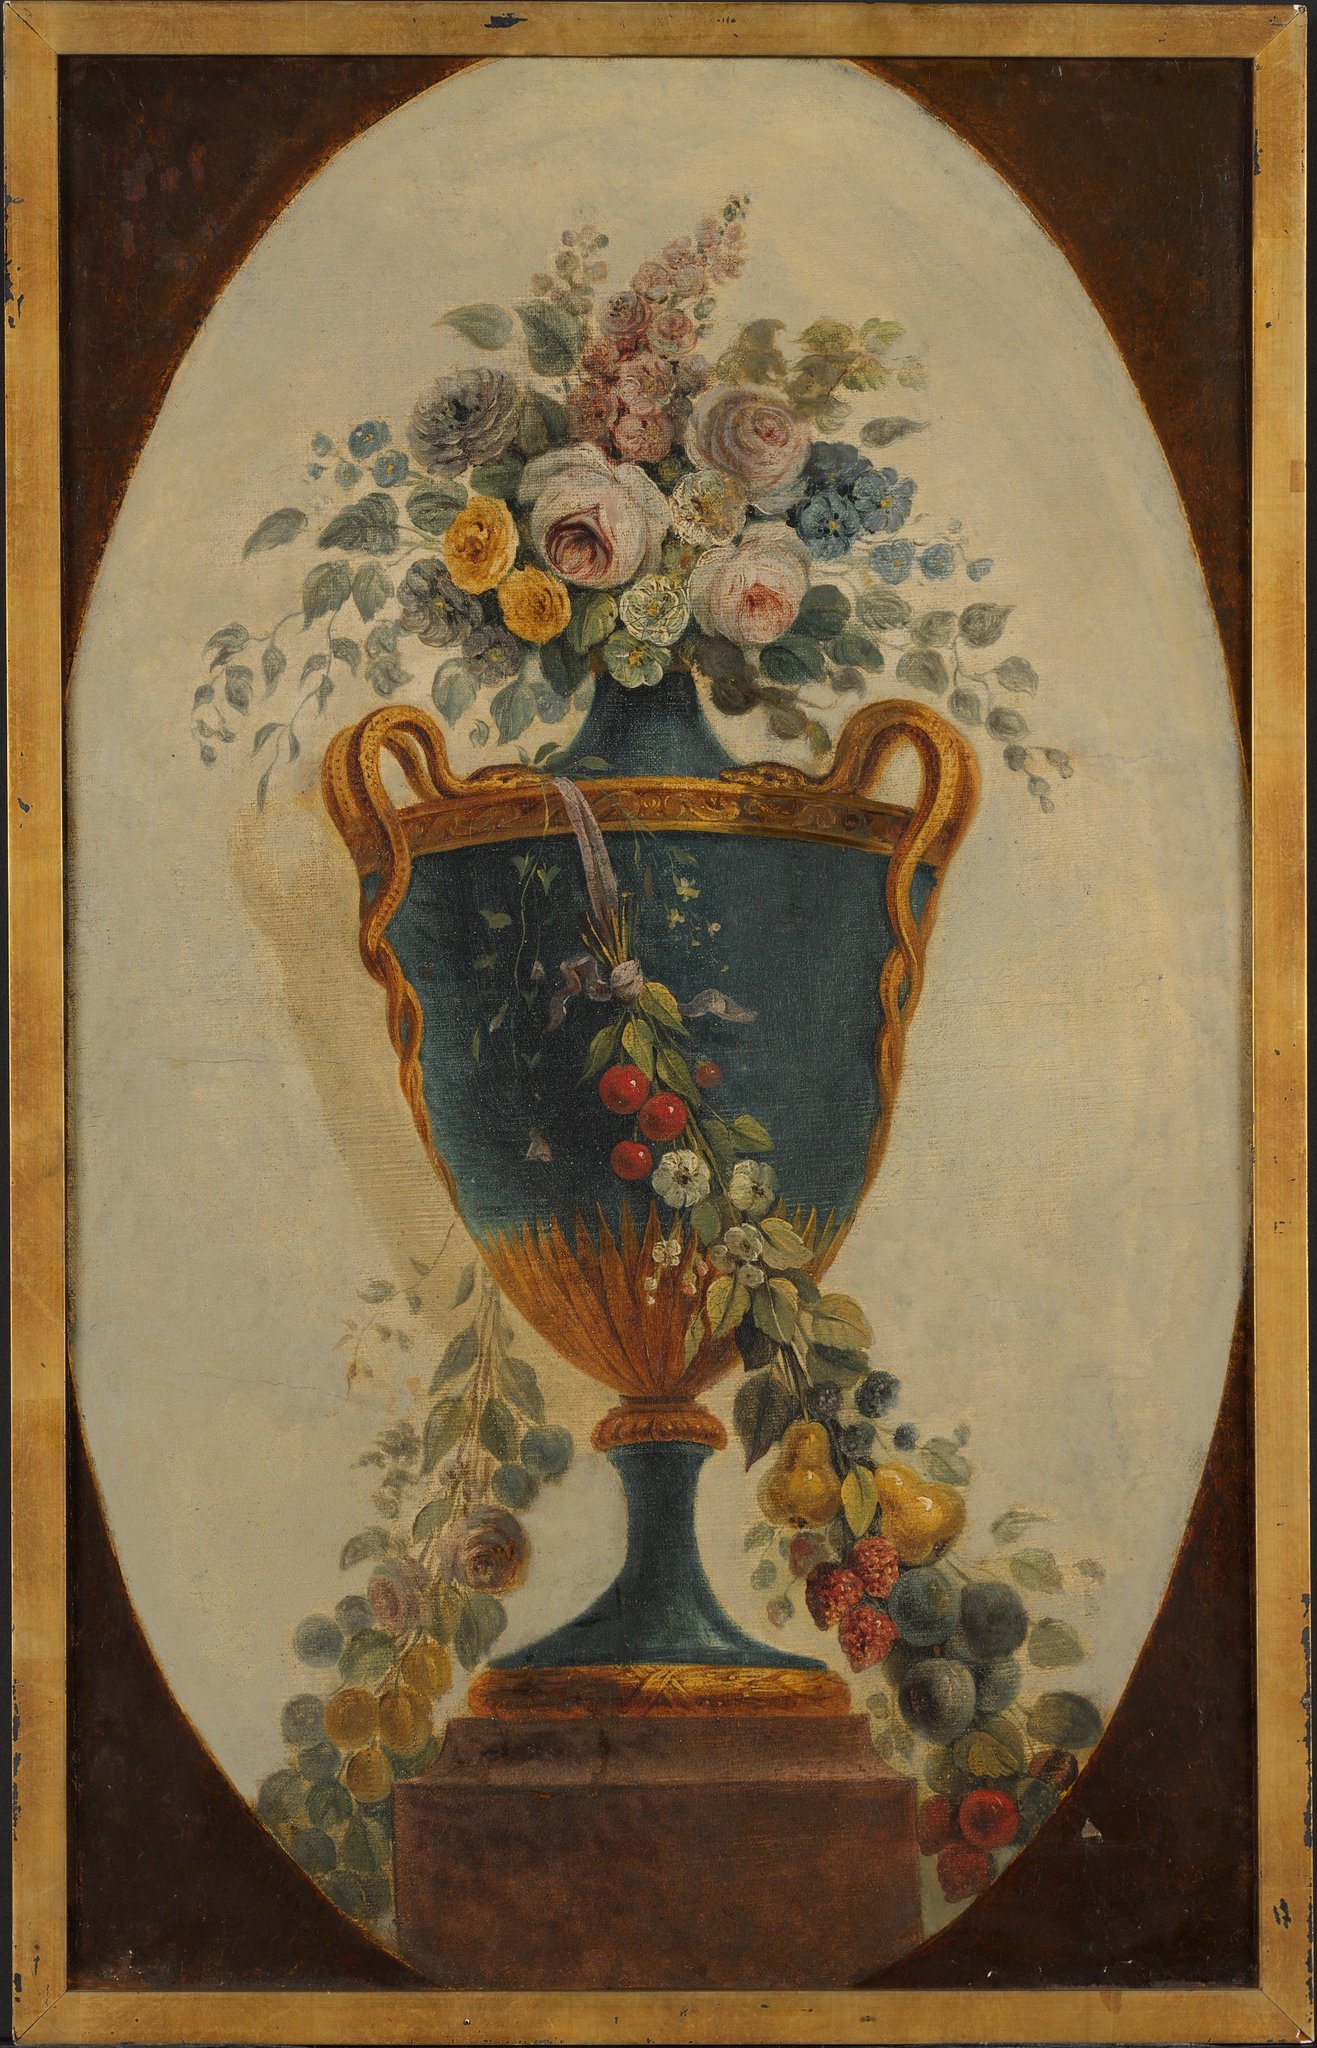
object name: panel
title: Vase of Flowers Draped with Garlands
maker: french painter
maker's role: artist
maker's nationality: french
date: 1701-1800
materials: canvas, oil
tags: garlands,fruit,roses